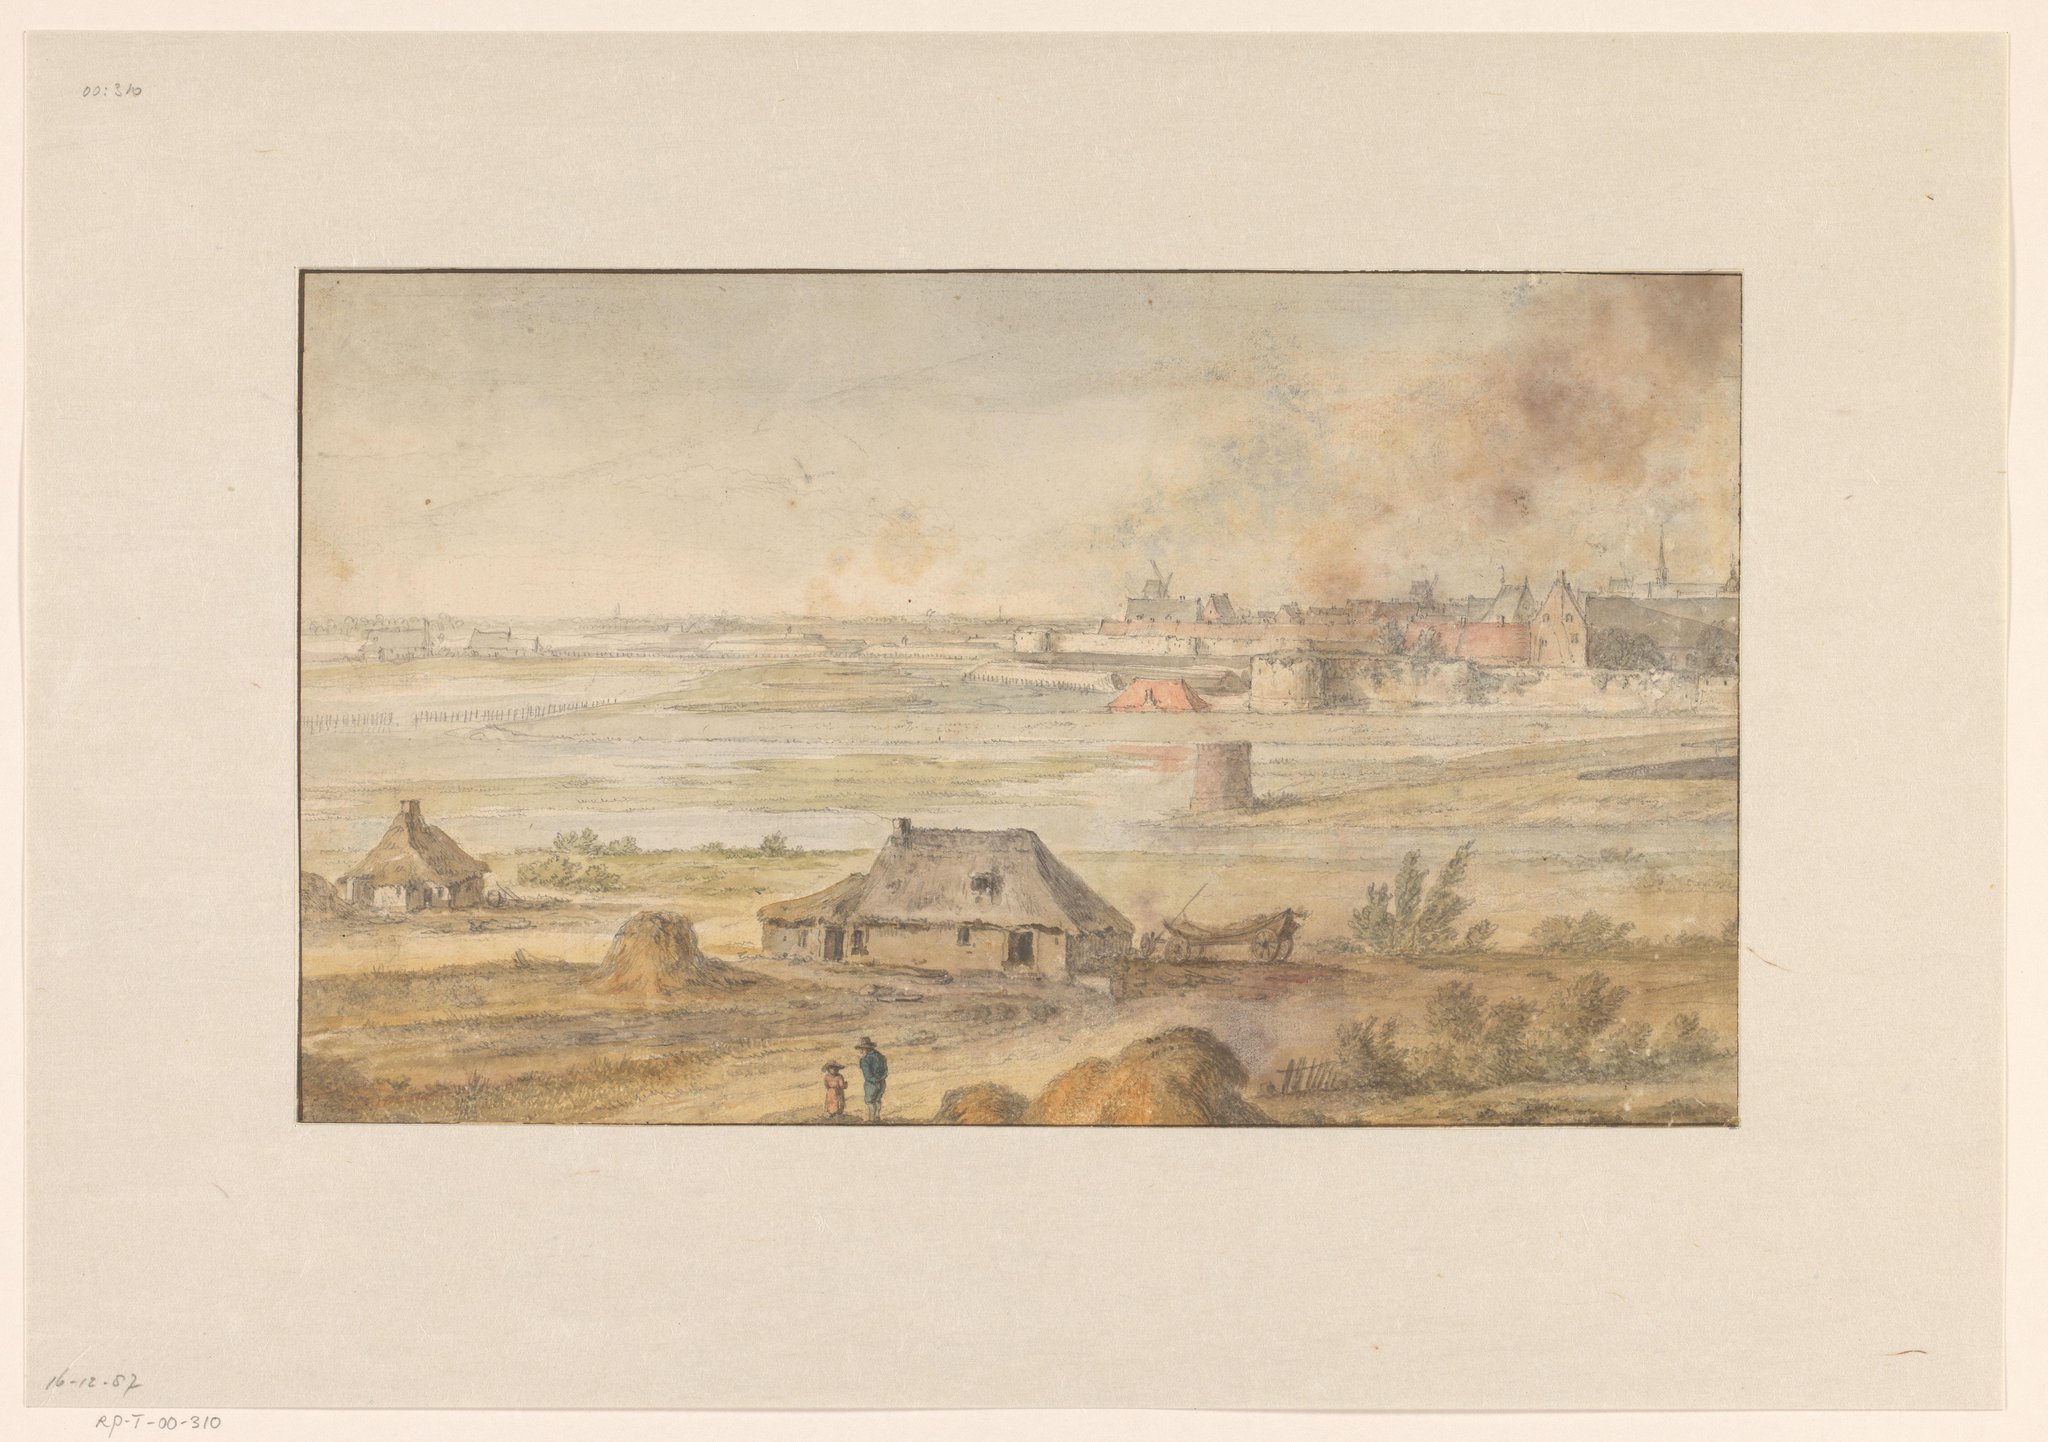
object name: drawing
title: Landschap met boerderijen en een ommuurde stad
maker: Anonymous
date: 1600-1699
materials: paper, watercolor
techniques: brush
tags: farm or solitary house in landscape, prospect of city, town panorama, silhouette of city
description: Vlak landschap met boerderijen op de voorgrond en in de verte een ommuurde stad.